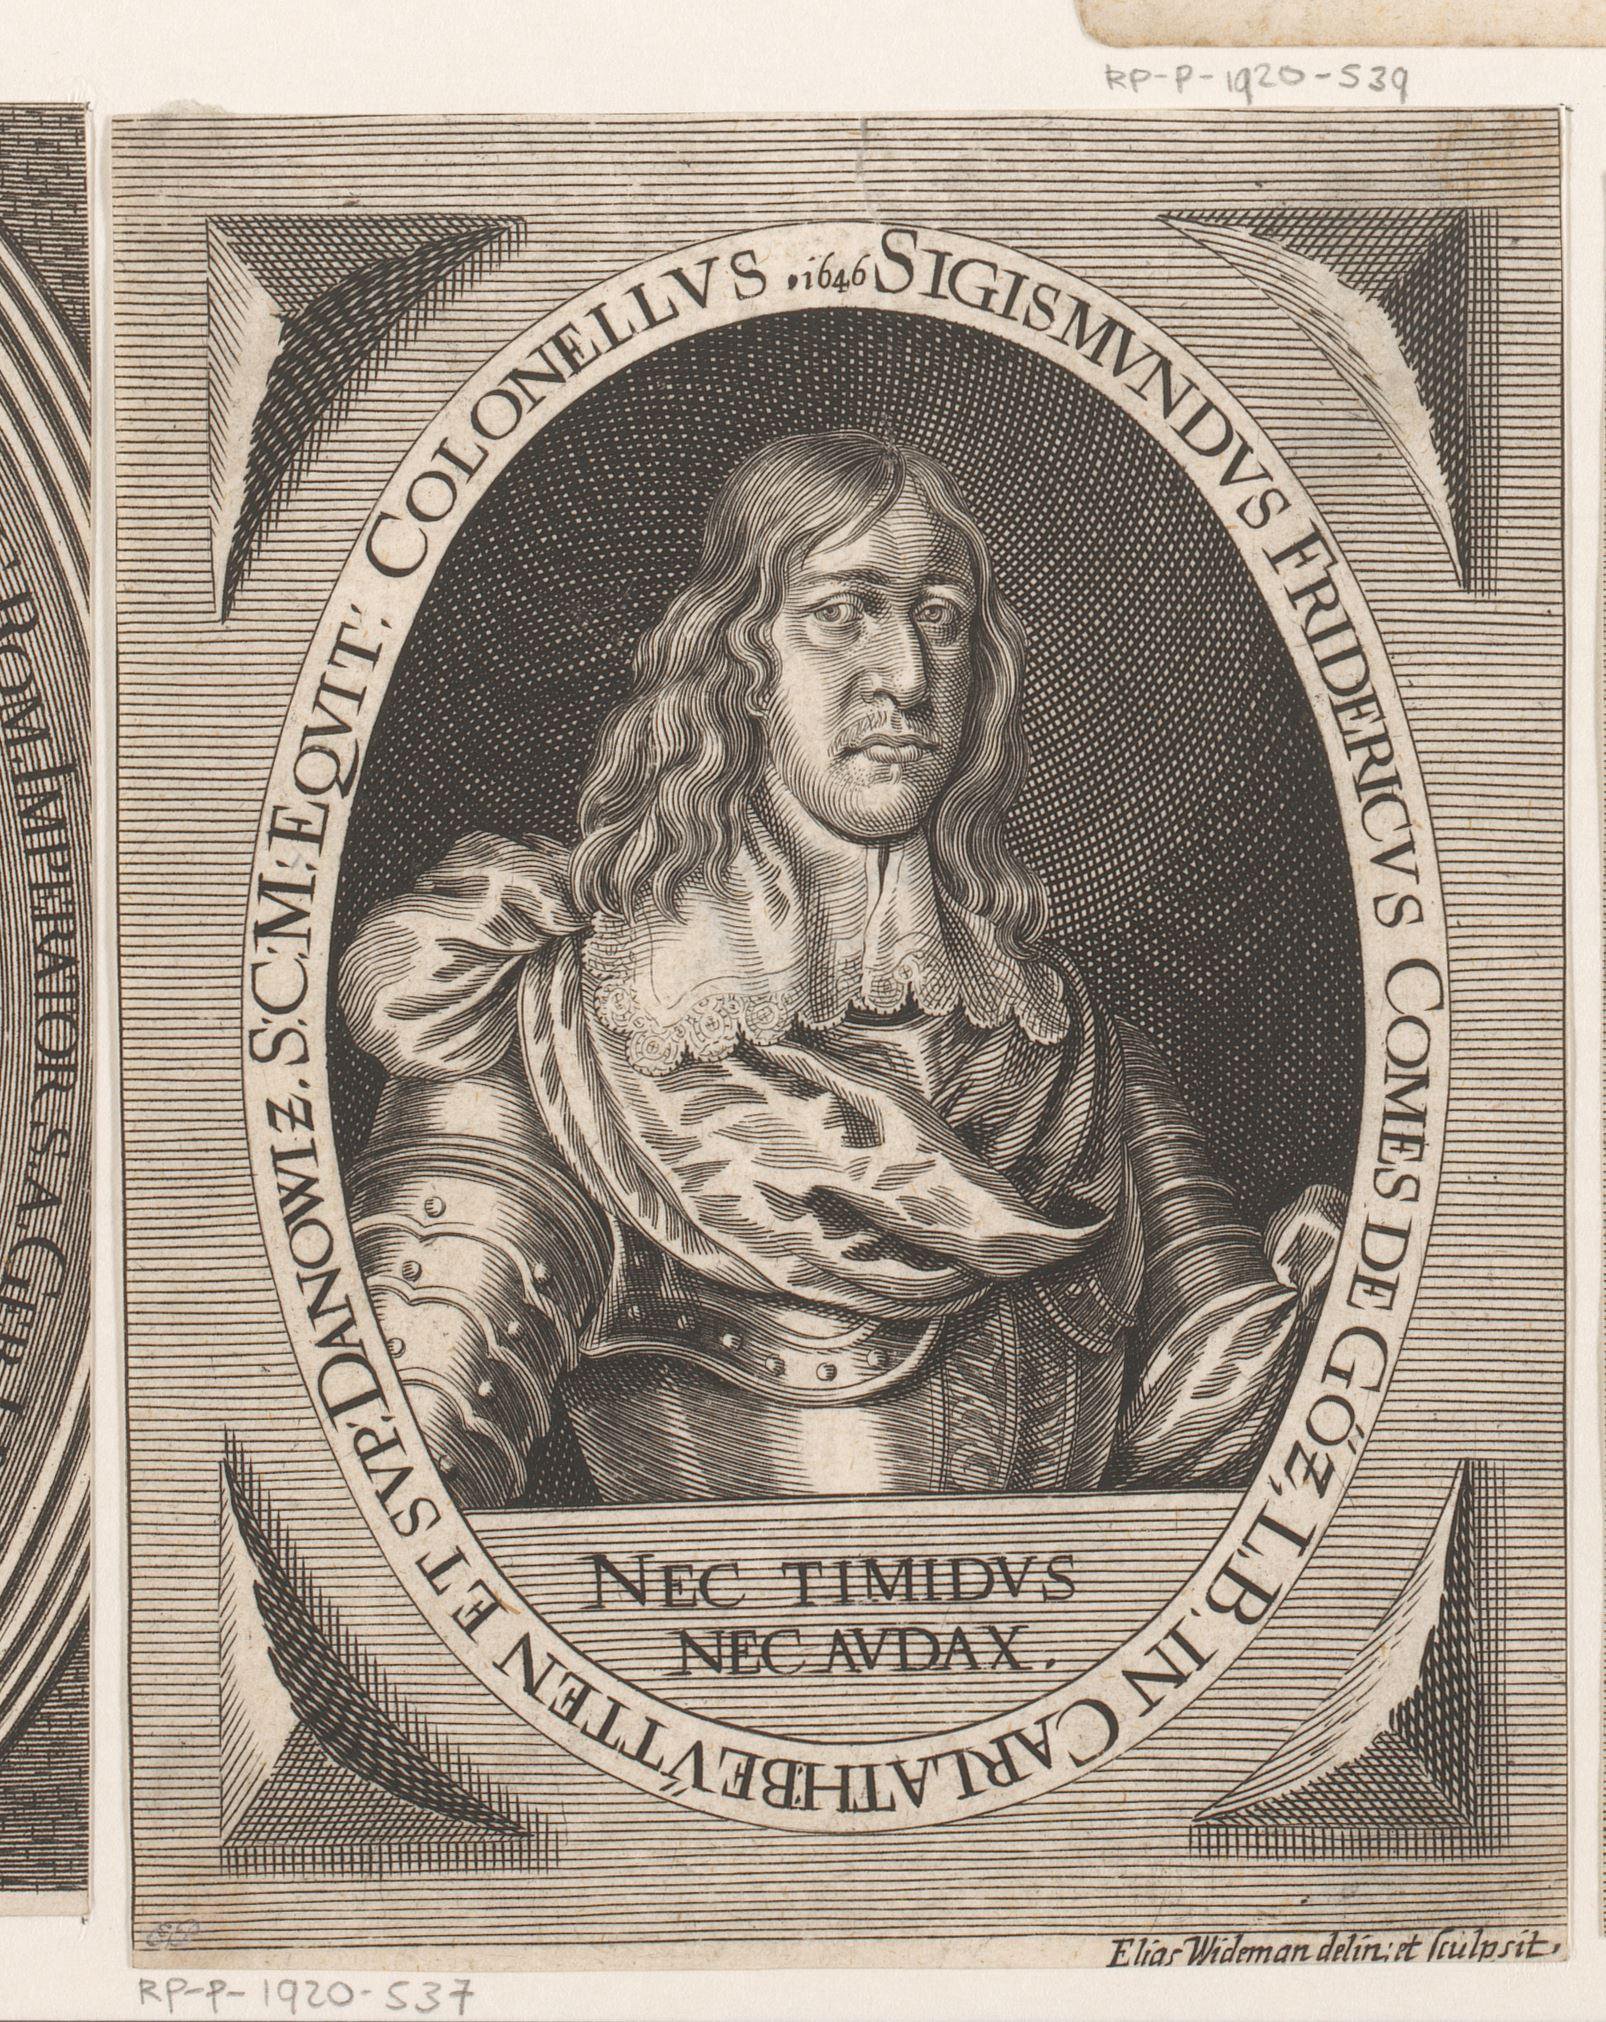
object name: print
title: Portret van Sigmund Friedrich von Götz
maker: elias widemann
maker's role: print maker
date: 1646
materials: paper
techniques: engraving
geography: vienna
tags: historical persons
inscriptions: inscription: ‘EP’, number: ‘N17742 AR’, collector's mark: Lugt 2228